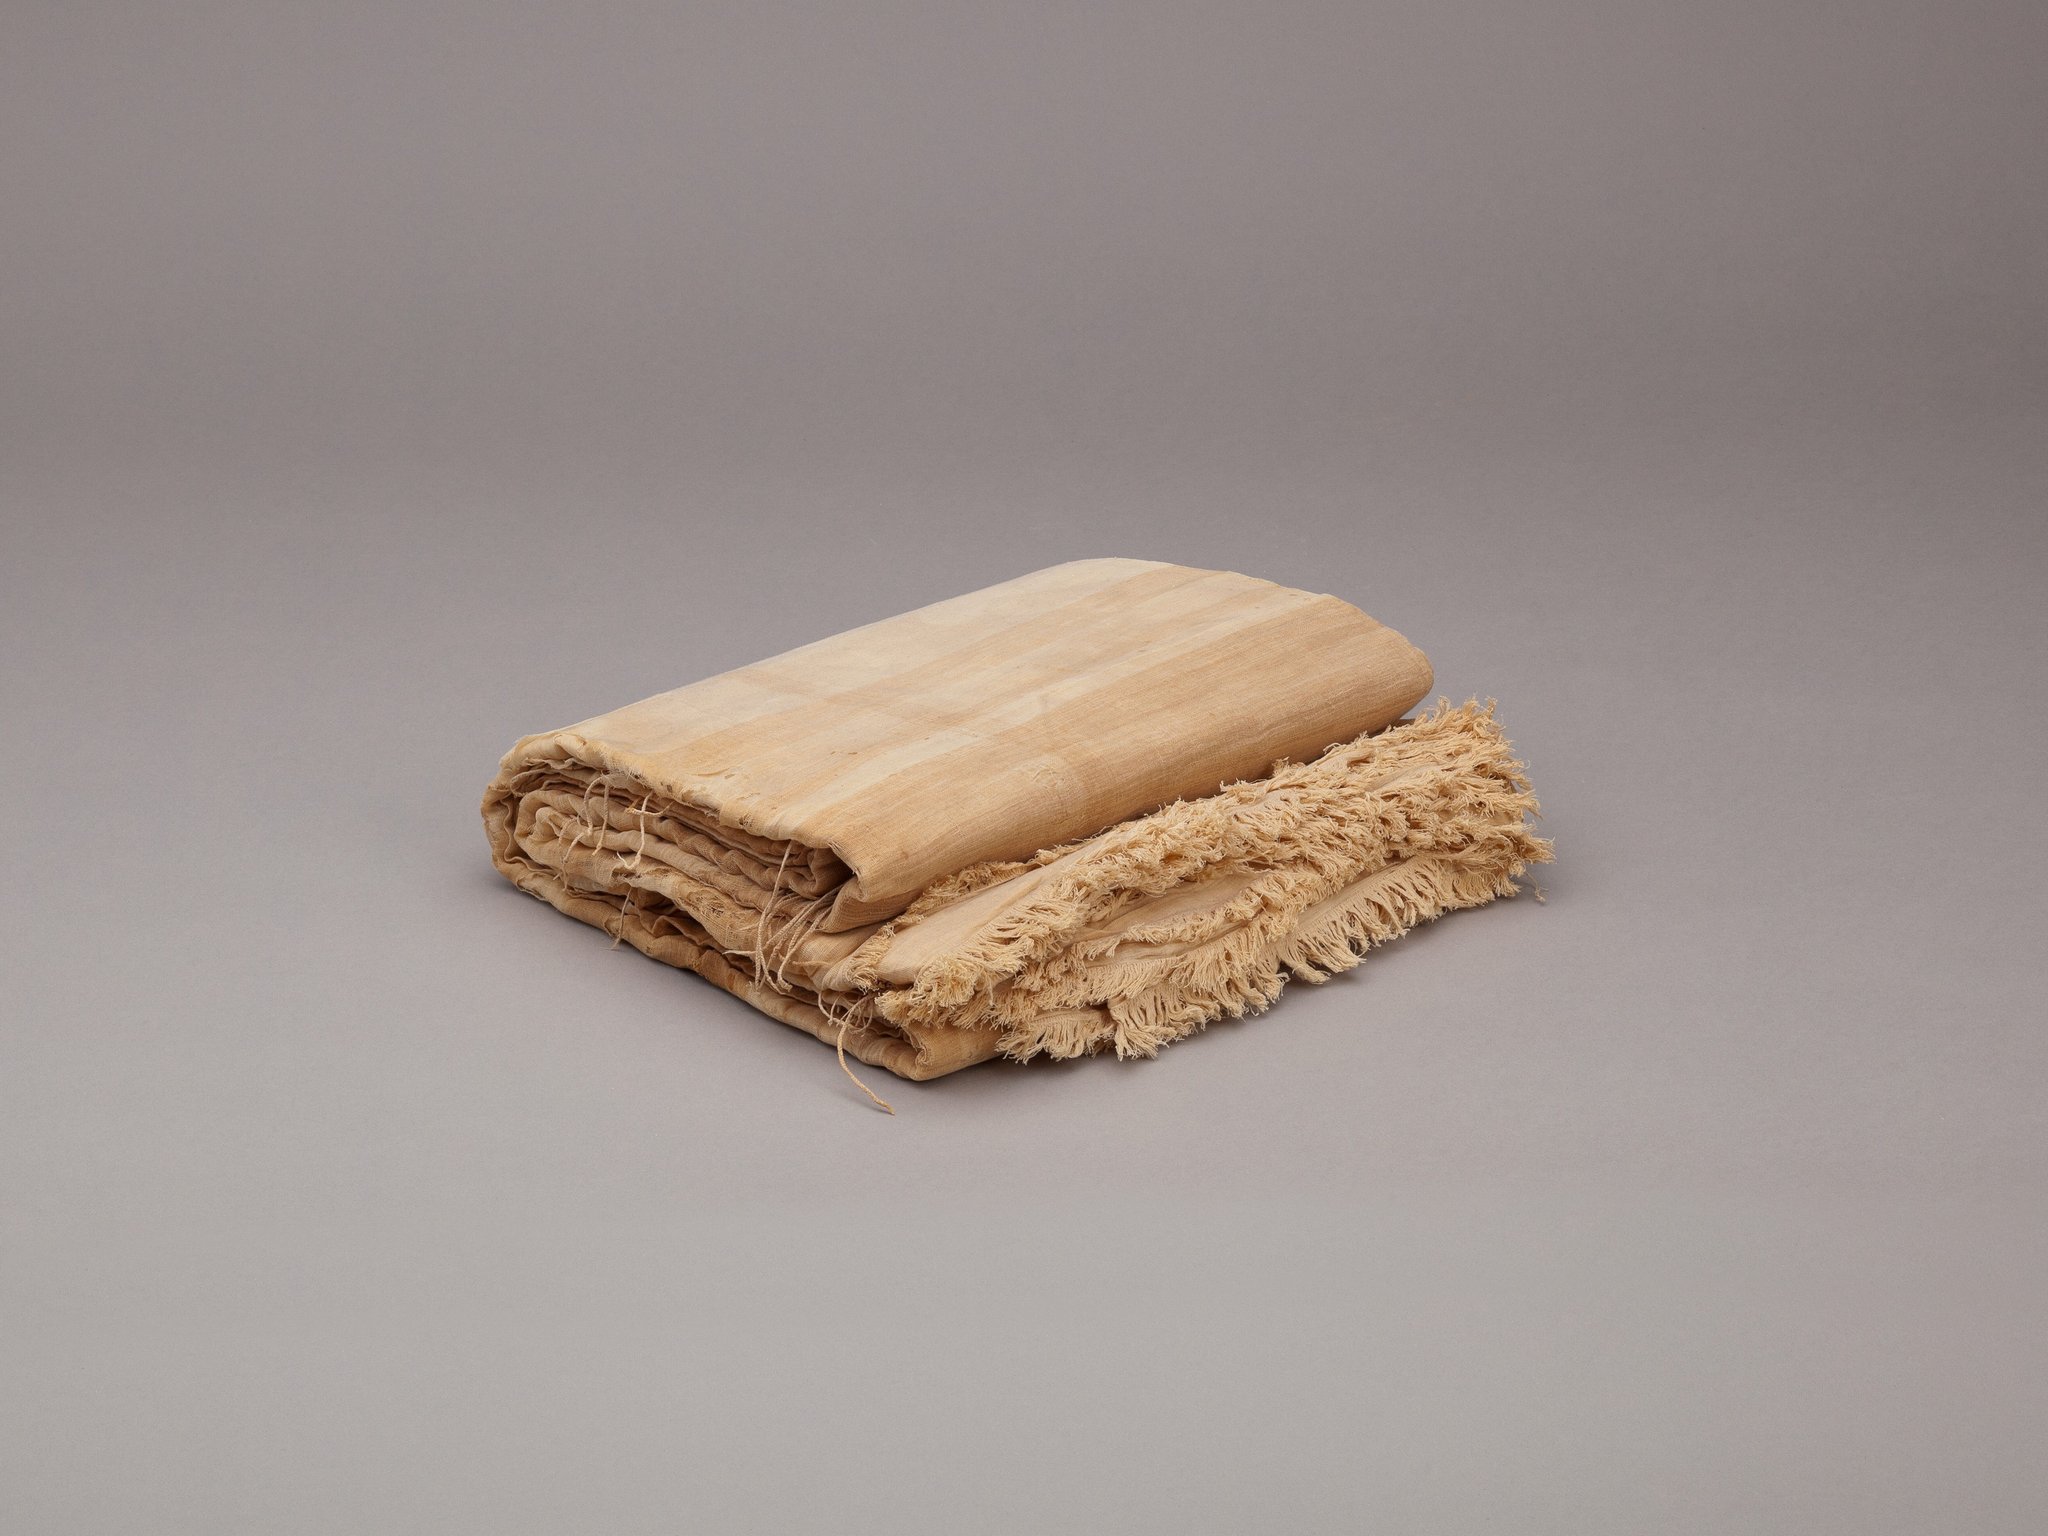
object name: linen mark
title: Sheet, linen mark, fine spin, medium weave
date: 1492-1473 BCE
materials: linen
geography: egypt